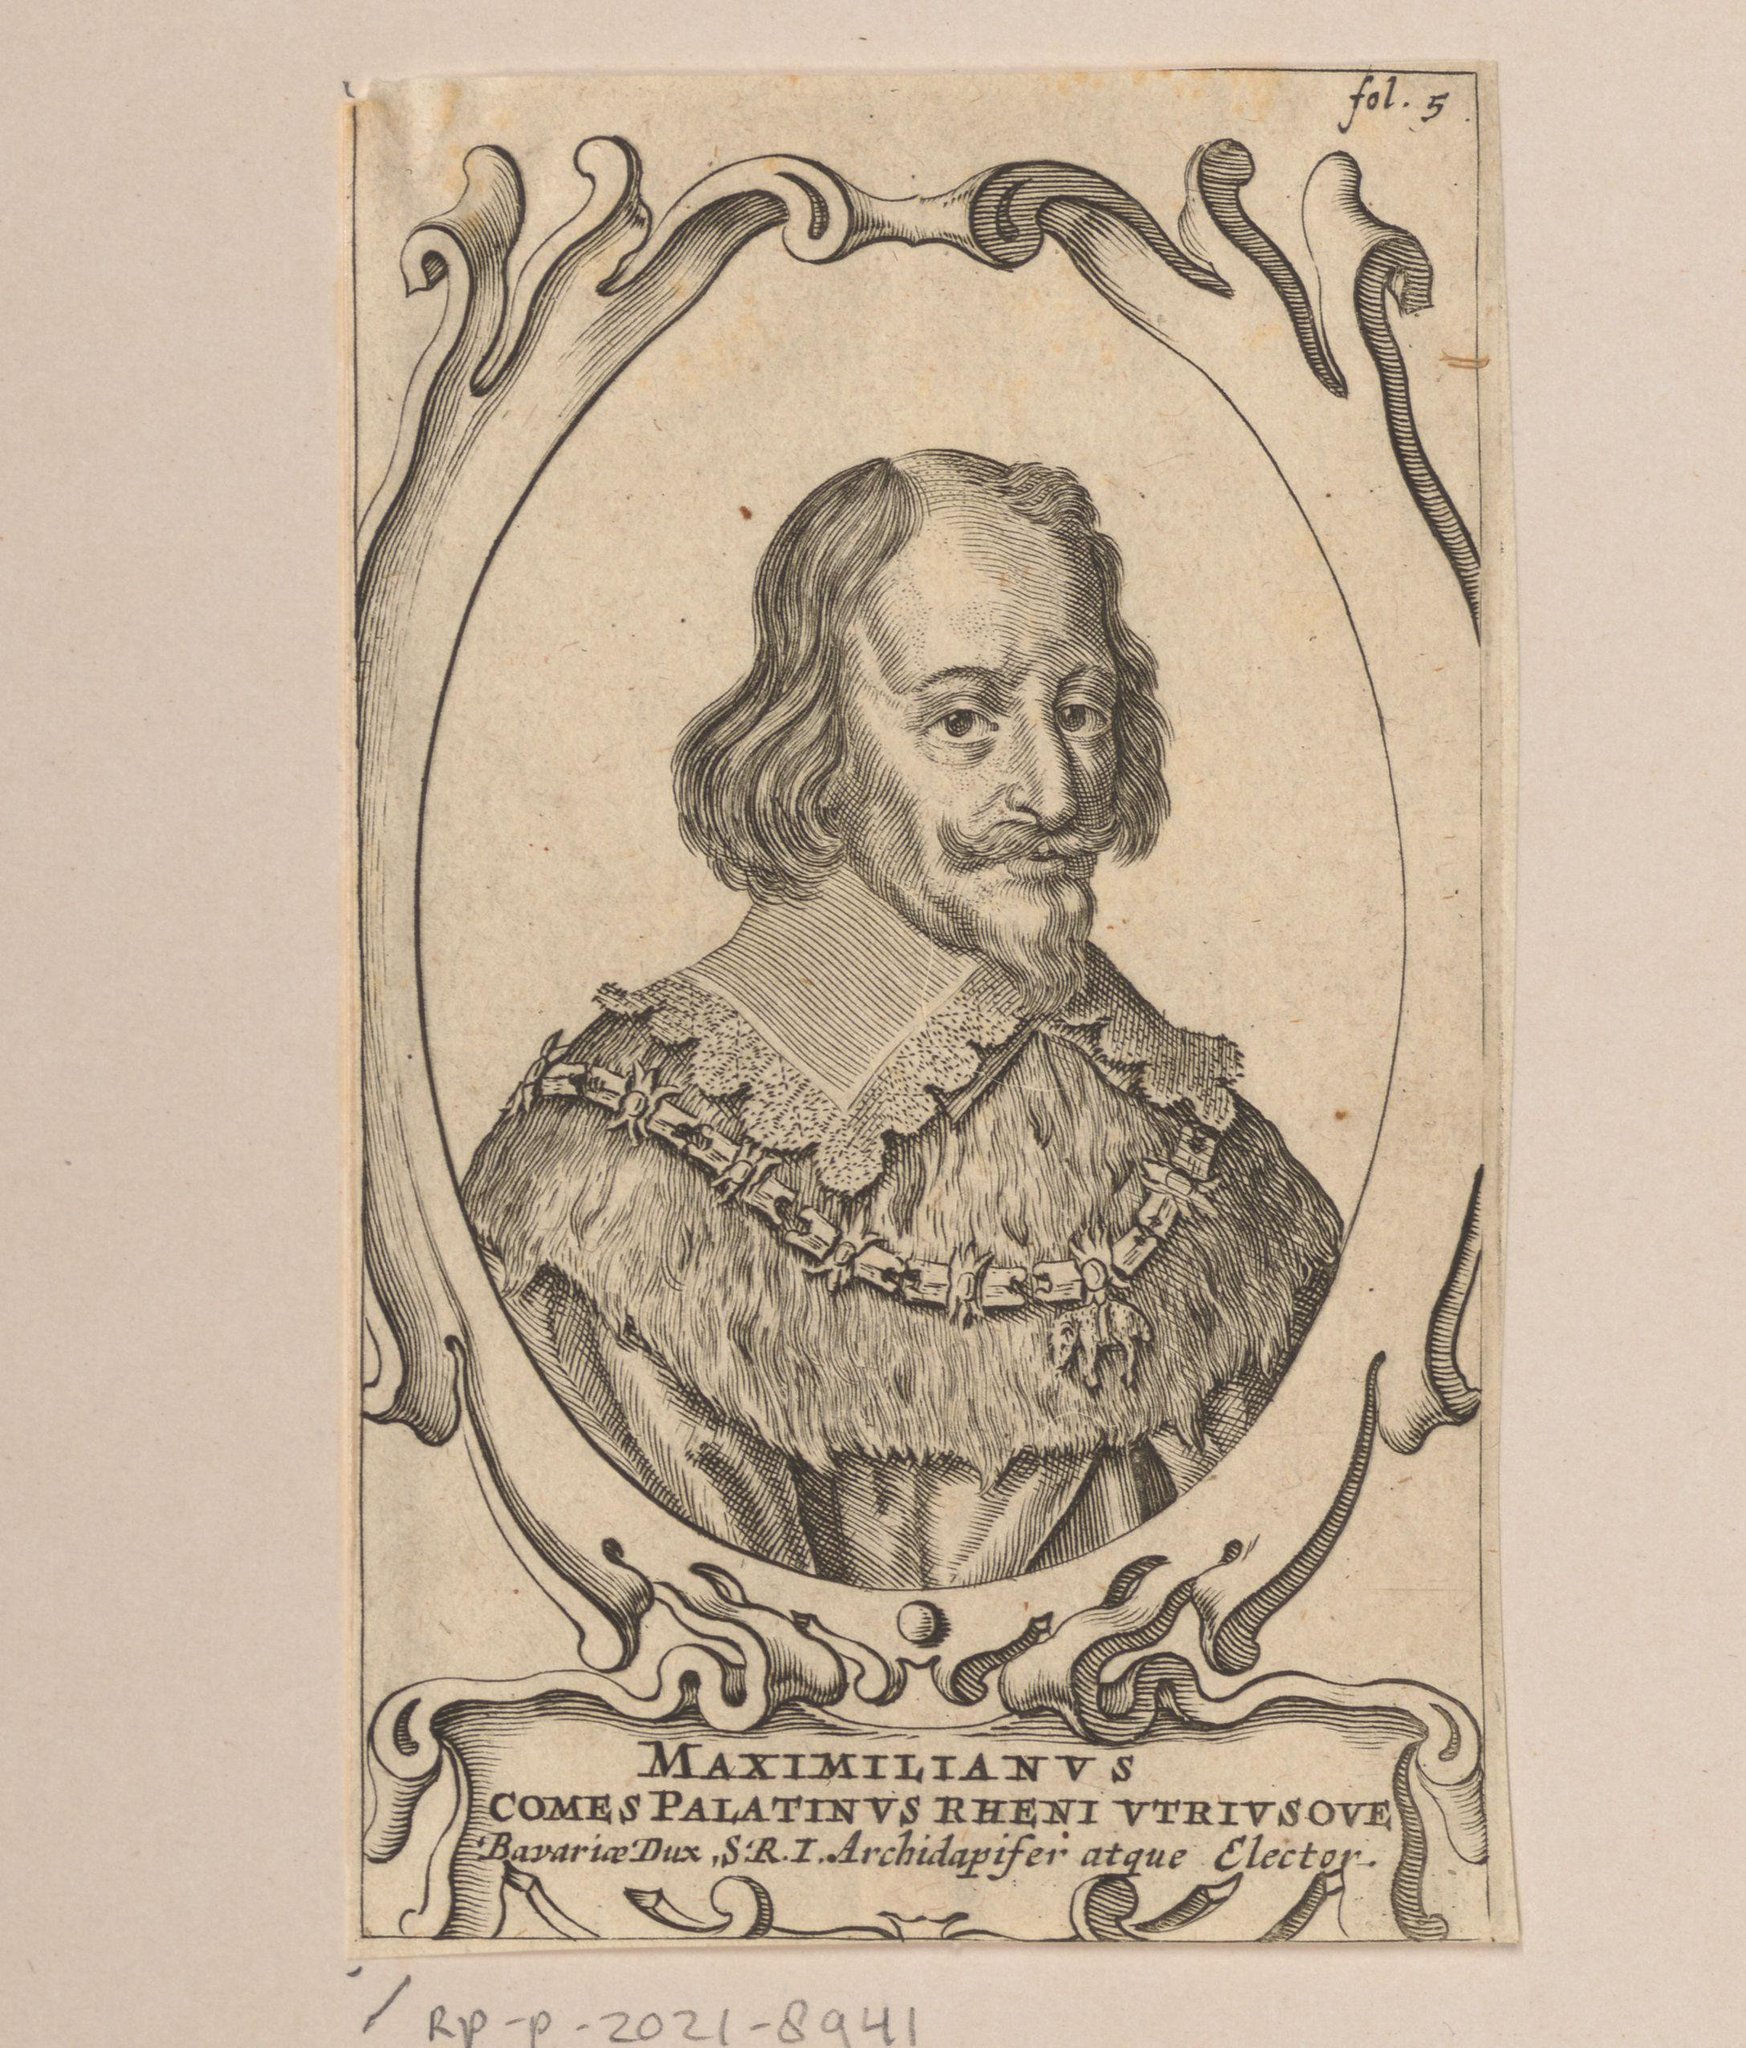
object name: book illustration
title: Portret van Maximiliaan I van Beieren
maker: Anonymous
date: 1656-1666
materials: paper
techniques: engraving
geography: northern netherlands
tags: maximiliaan i (keurvorst van beieren), rocaille ornament, historical persons, knighthood order of the golden fleece - insignia of a knighthood order, e.g.: badge, chain (with name of order)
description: Prent waarschijnlijk uit: Brachelius, Johannes Adolphus. Historia nostri temporis, dat is geschiedenis onses tijts (…). Rotterdam: Andries van Hoogenhuysen, 1656. Prent ook gebruikt in de 1659- en 1666-editie.